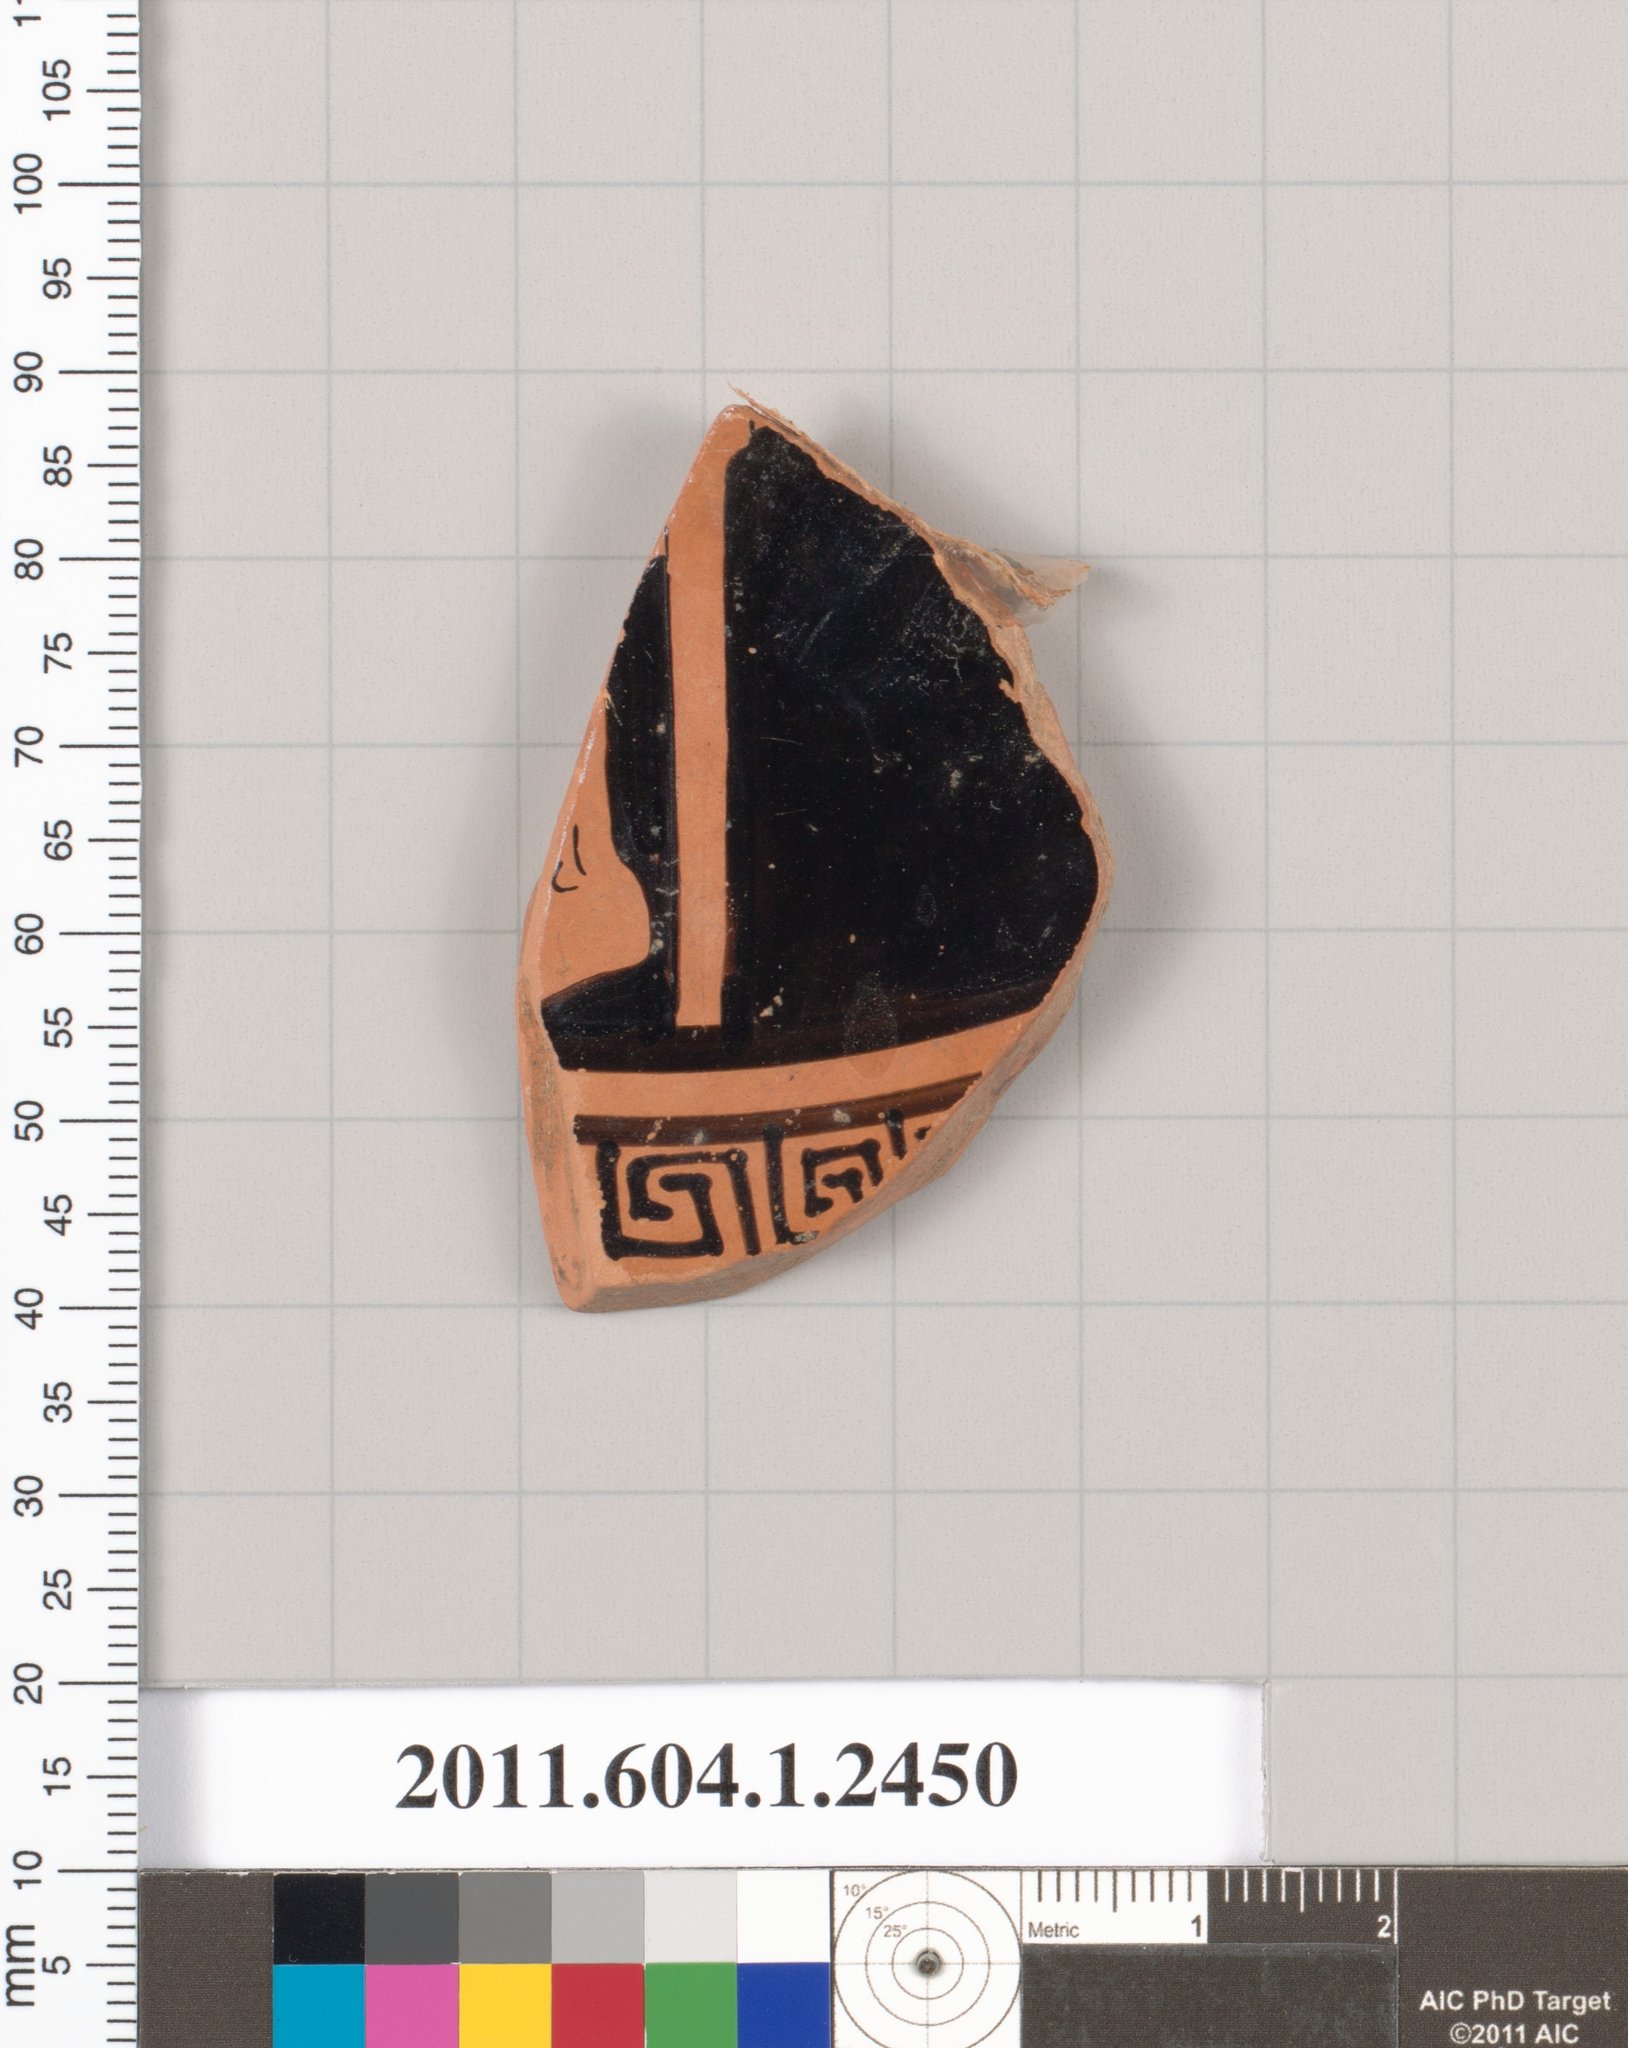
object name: kylix fragment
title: Terracotta fragment of a kylix (drinking cup)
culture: greek, attic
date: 490-480 BCE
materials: terracotta